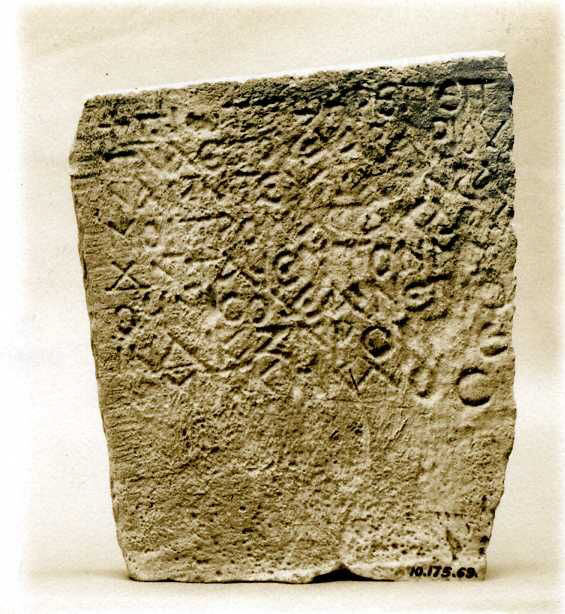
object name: stele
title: Inscribed Stele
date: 501-700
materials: limestone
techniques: incising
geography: egypt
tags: coptic